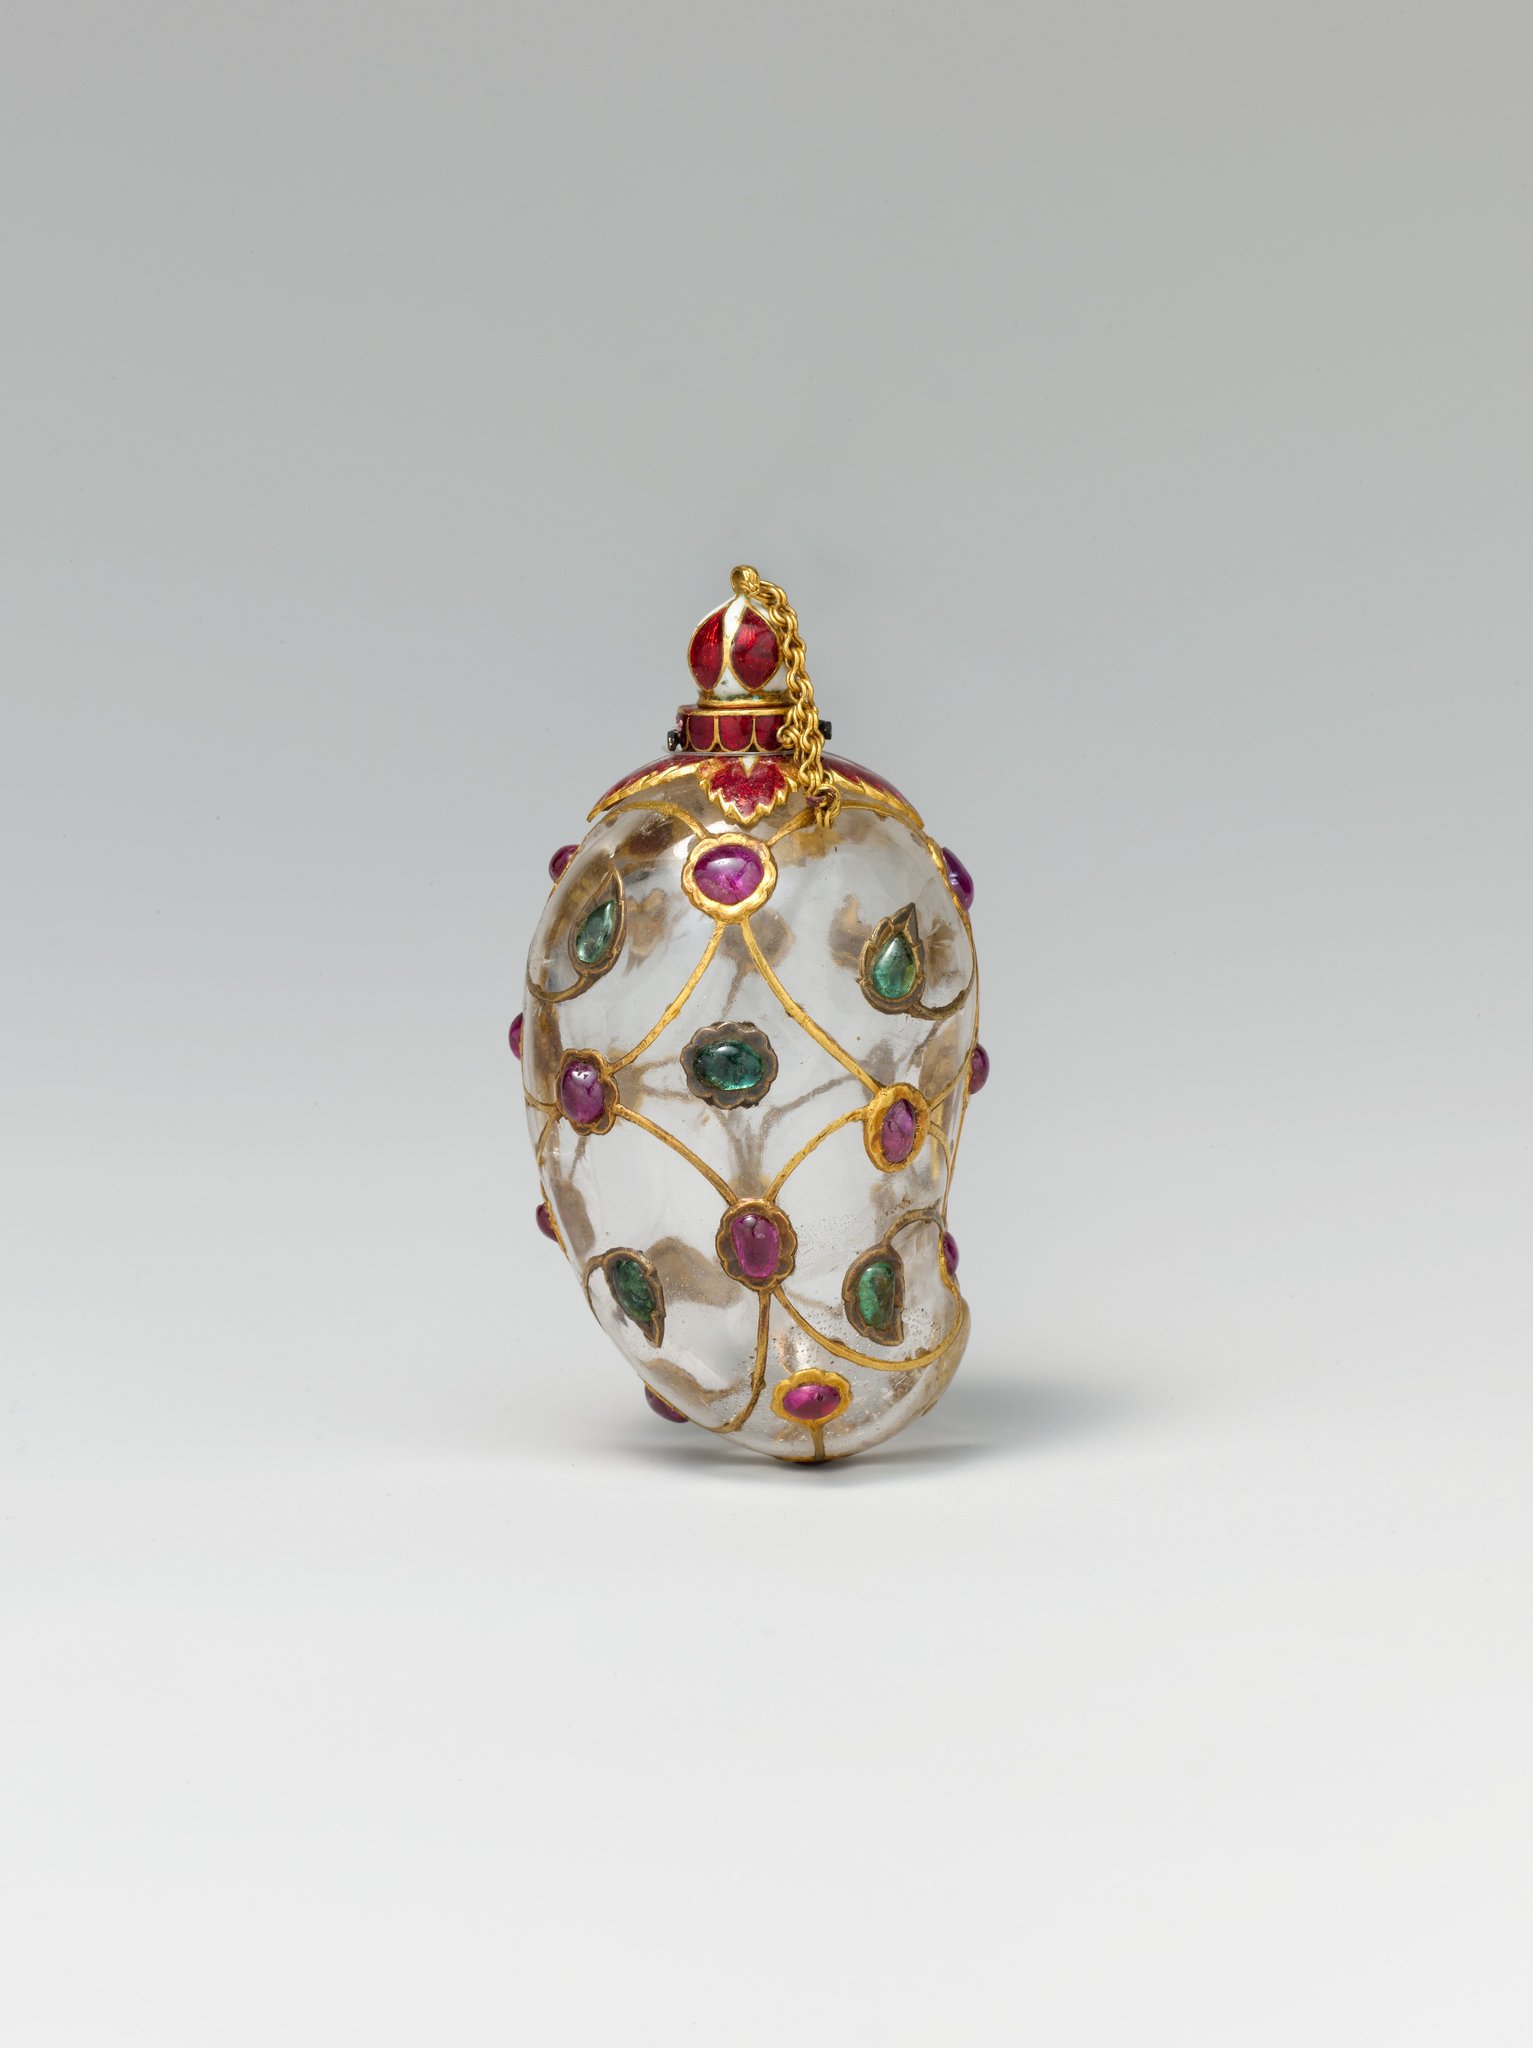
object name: flask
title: Mango-Shaped Flask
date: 1634-1666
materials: gemstone, enamel, gold, quartz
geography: india